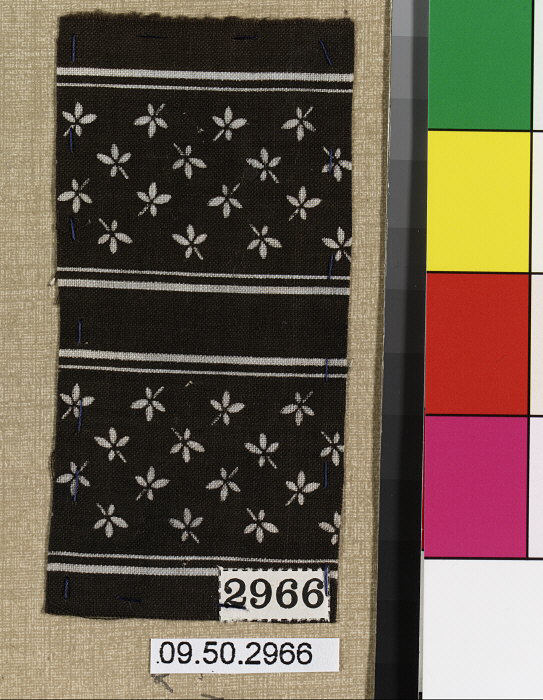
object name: piece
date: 1801-1900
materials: cotton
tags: leaves